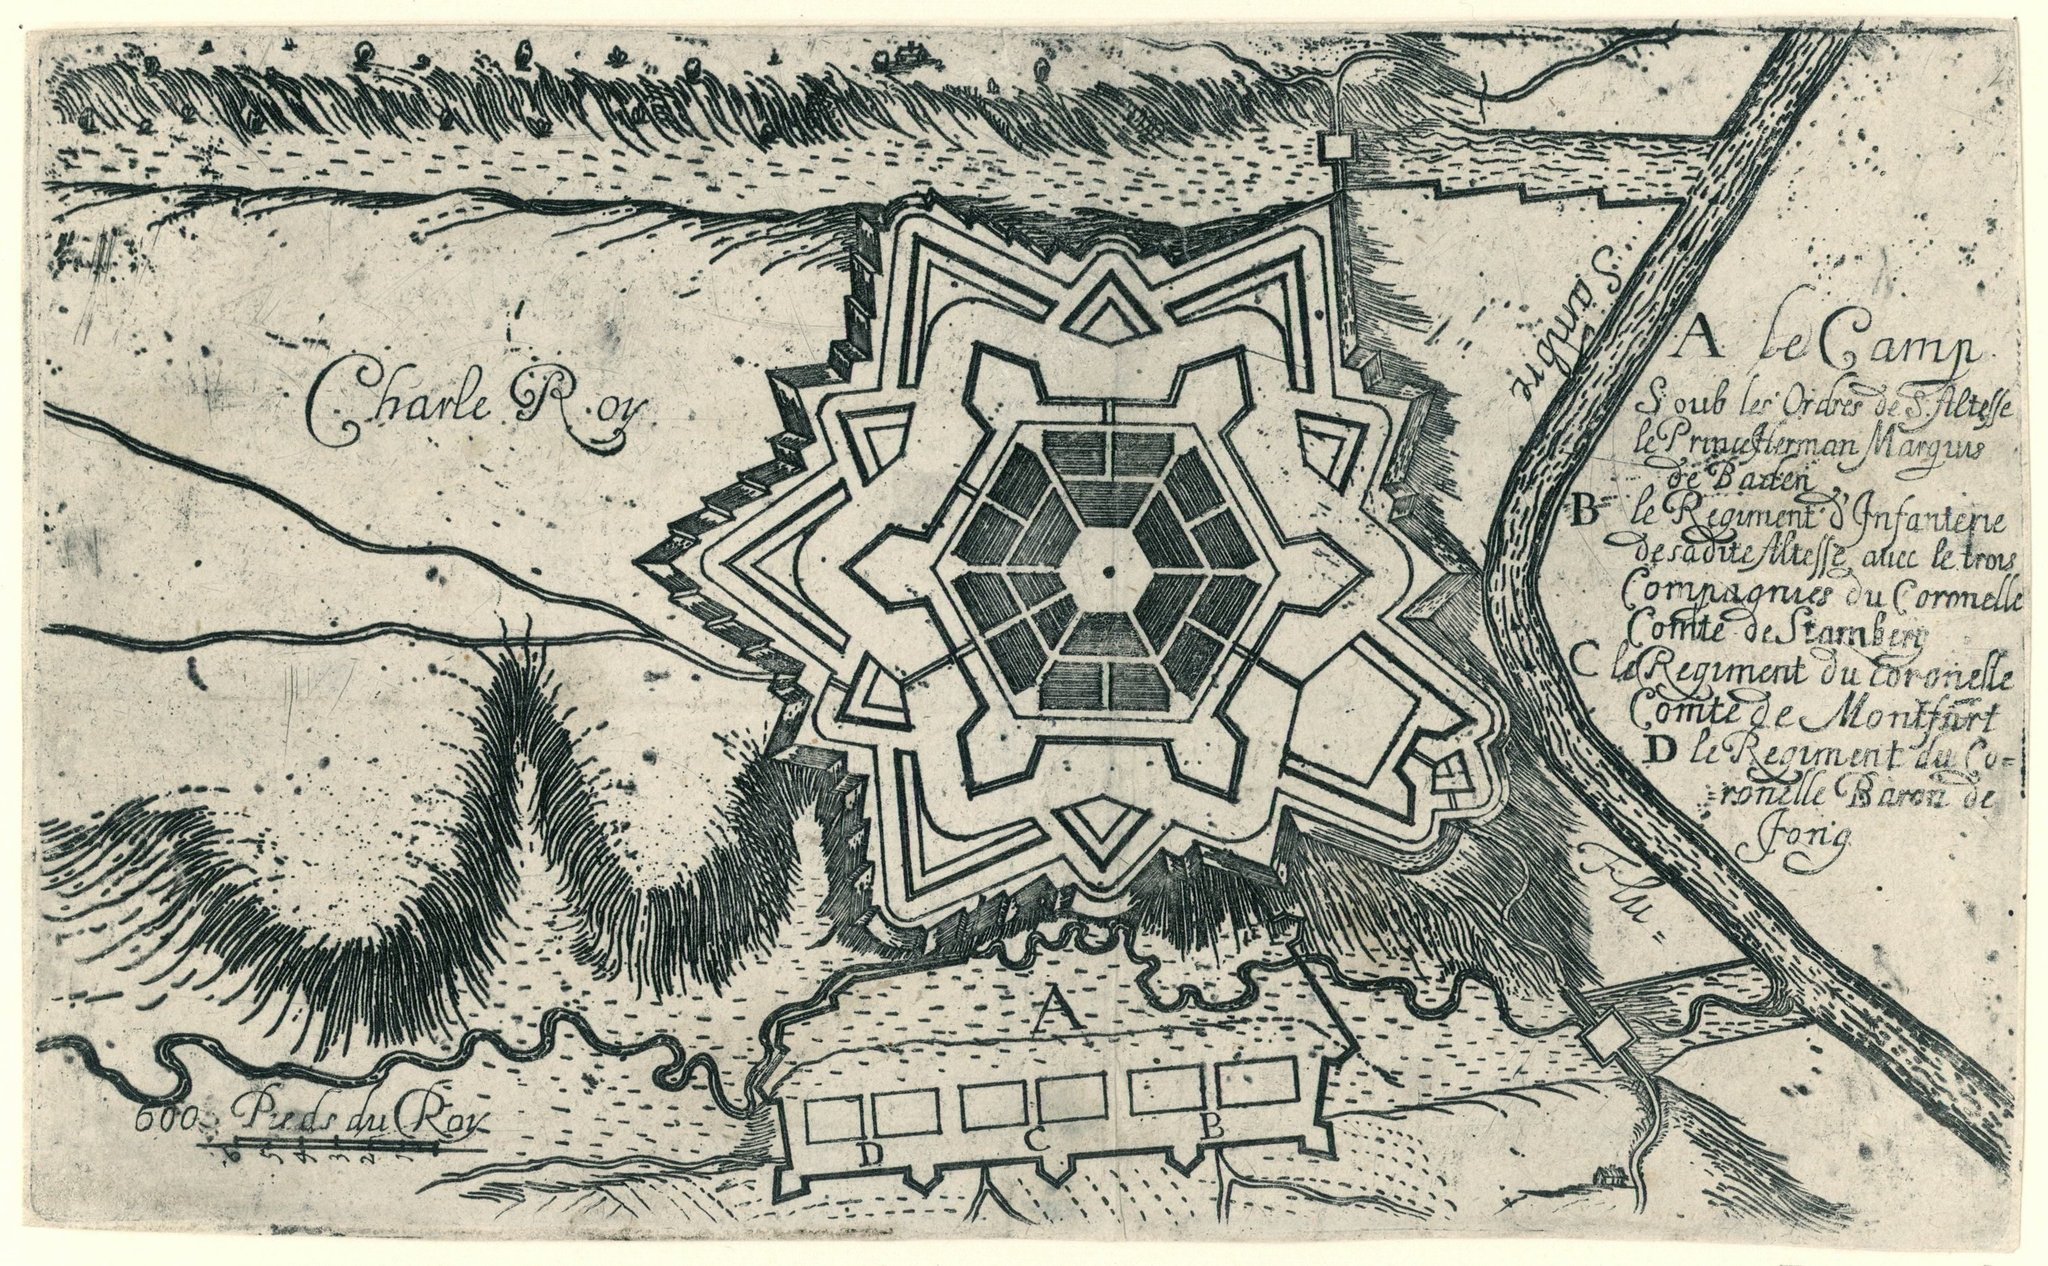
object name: print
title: Plattegrond van de vesting van Charleroi met de daar gelegerde troepen, ca. 1672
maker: Anonymous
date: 1672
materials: paper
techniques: etching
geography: southern netherlands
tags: maps of cities, rampjaar (disaster year)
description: Niet in Frederik Muller; door het RPK toegevoegd nummer. Geen onderdeel van de serie van twaalf gezichten op vestingen en steden ingenomen door de Fransen en de bisschop van Munster in 1672.